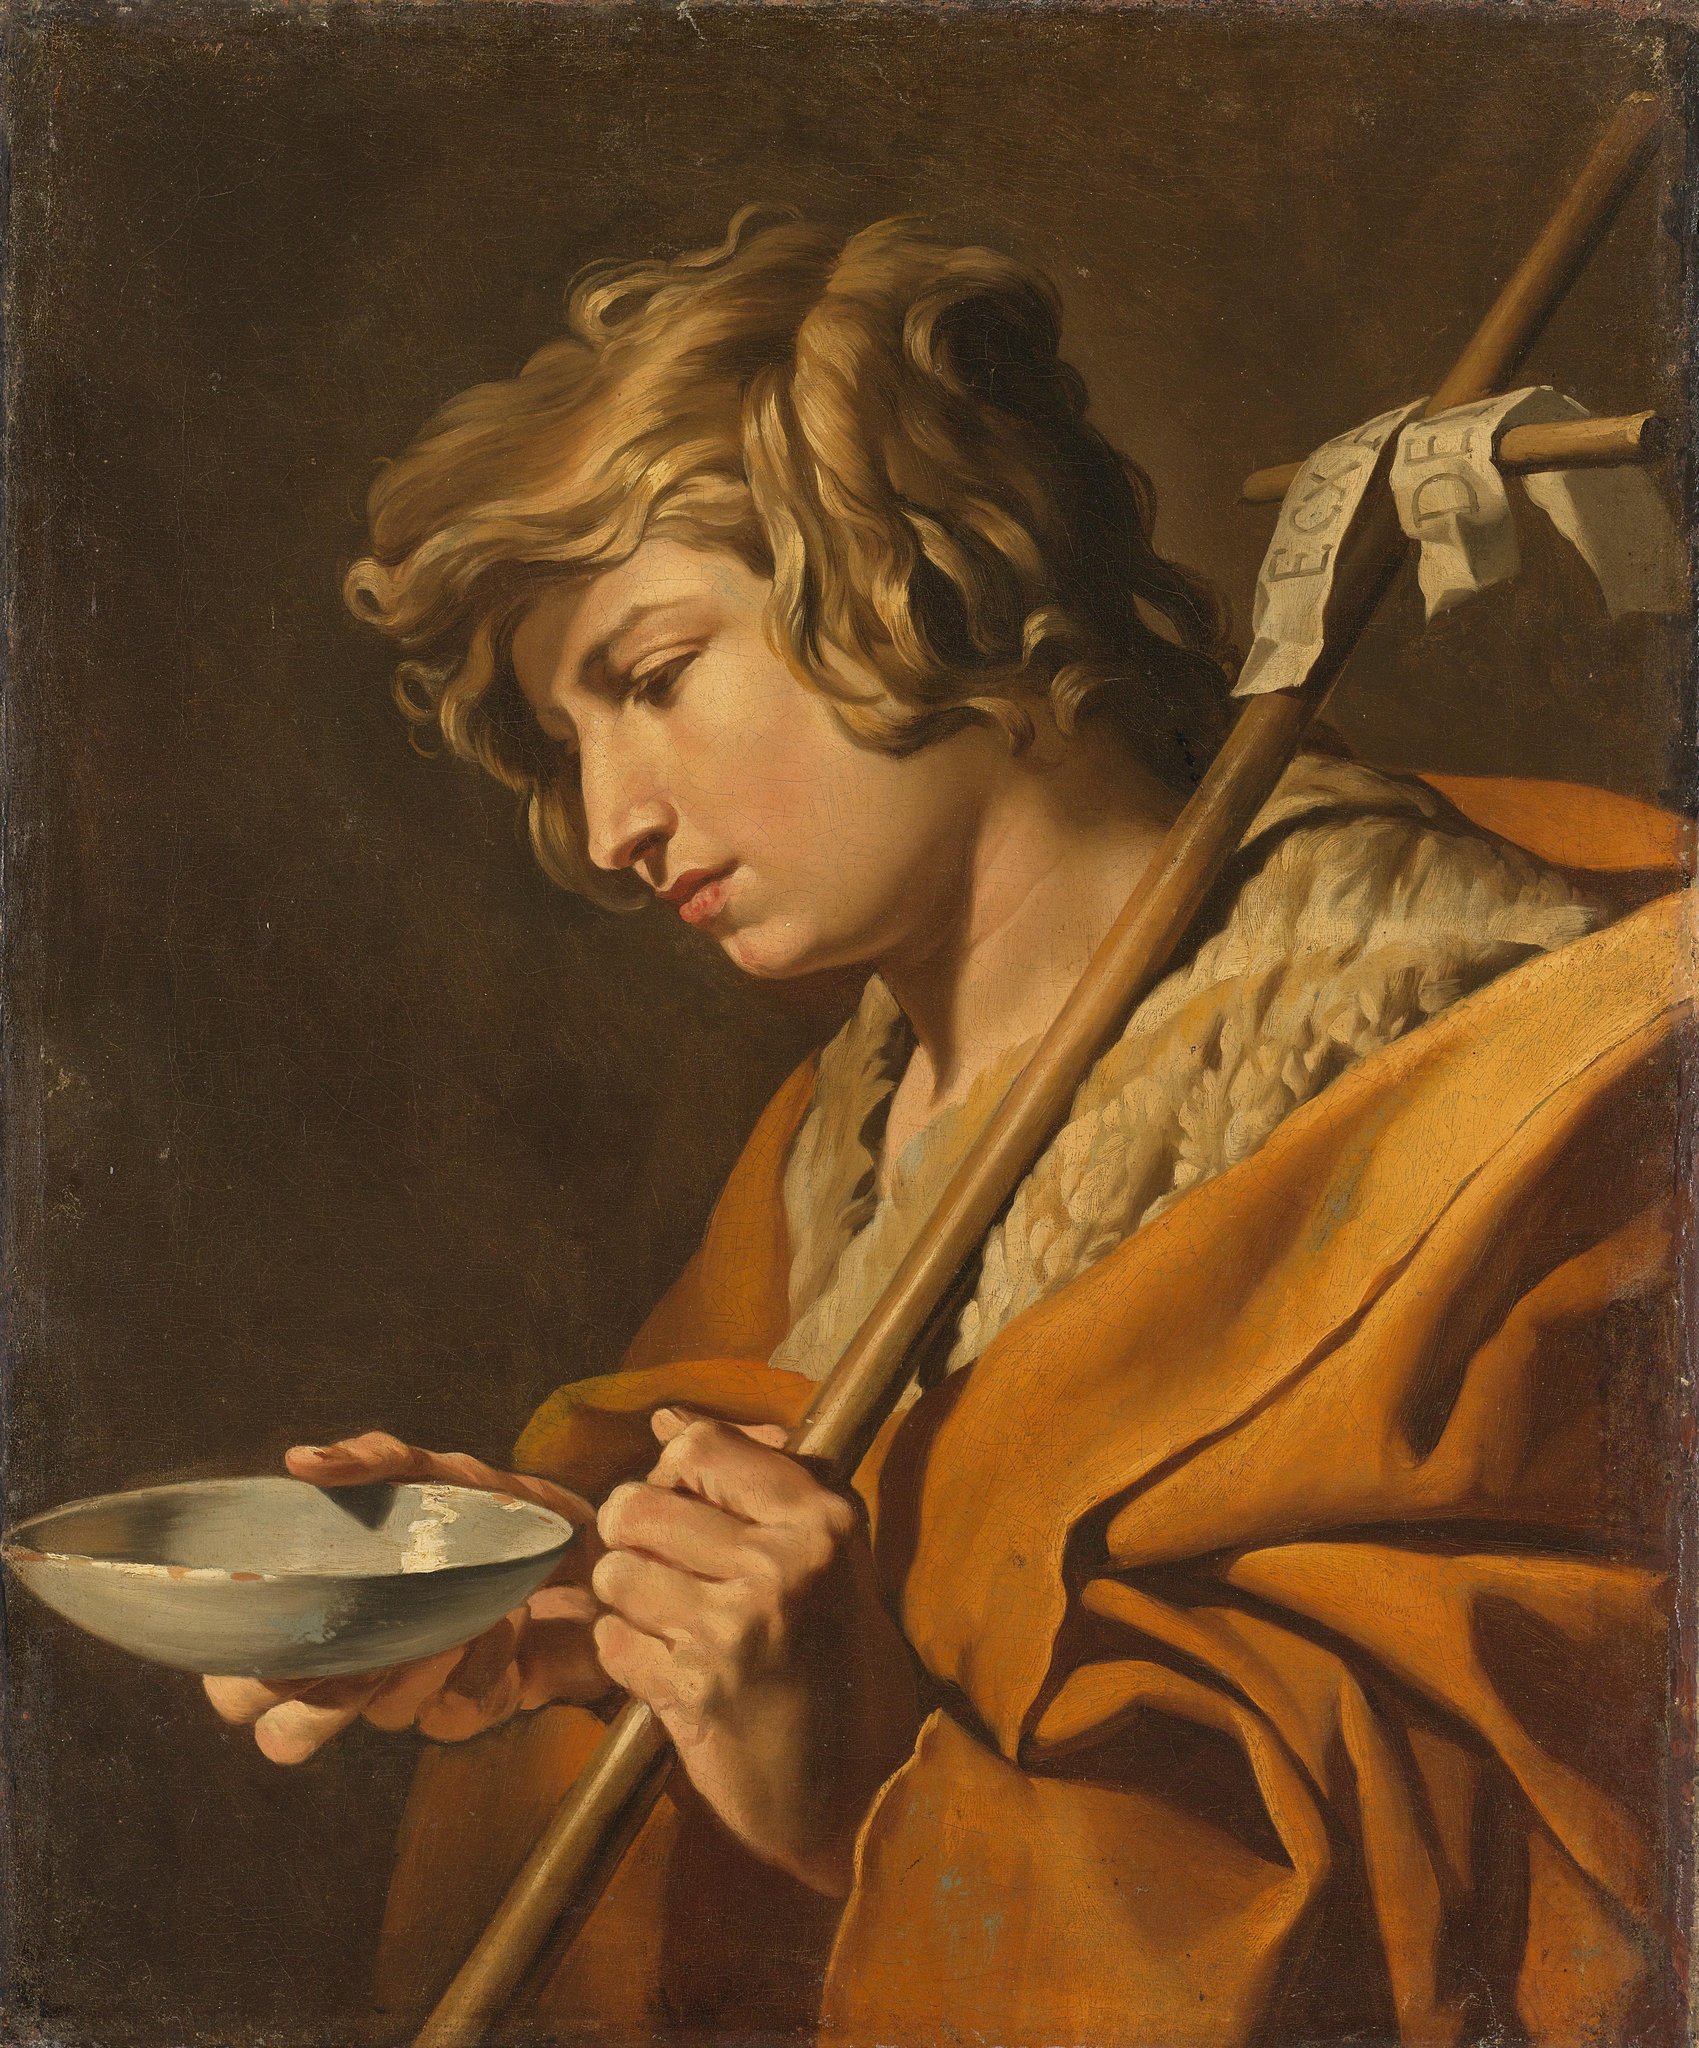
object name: painting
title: St John the Baptist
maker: matthias stom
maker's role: painter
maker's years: 1600-1649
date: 1630-1650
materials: canvas, oil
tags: john the baptist; possible attributes: book, reed cross, baptismal cup, honeycomb, lamb, staff - specific aspects ~ male saint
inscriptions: inscription, on the cross: ‘DEI’, inscription, on the cross: ‘ECXA’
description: Johannes de Doper, halffiguur in profiel naar links, een bakje met water in de rechterhand en een staf over de schouder.